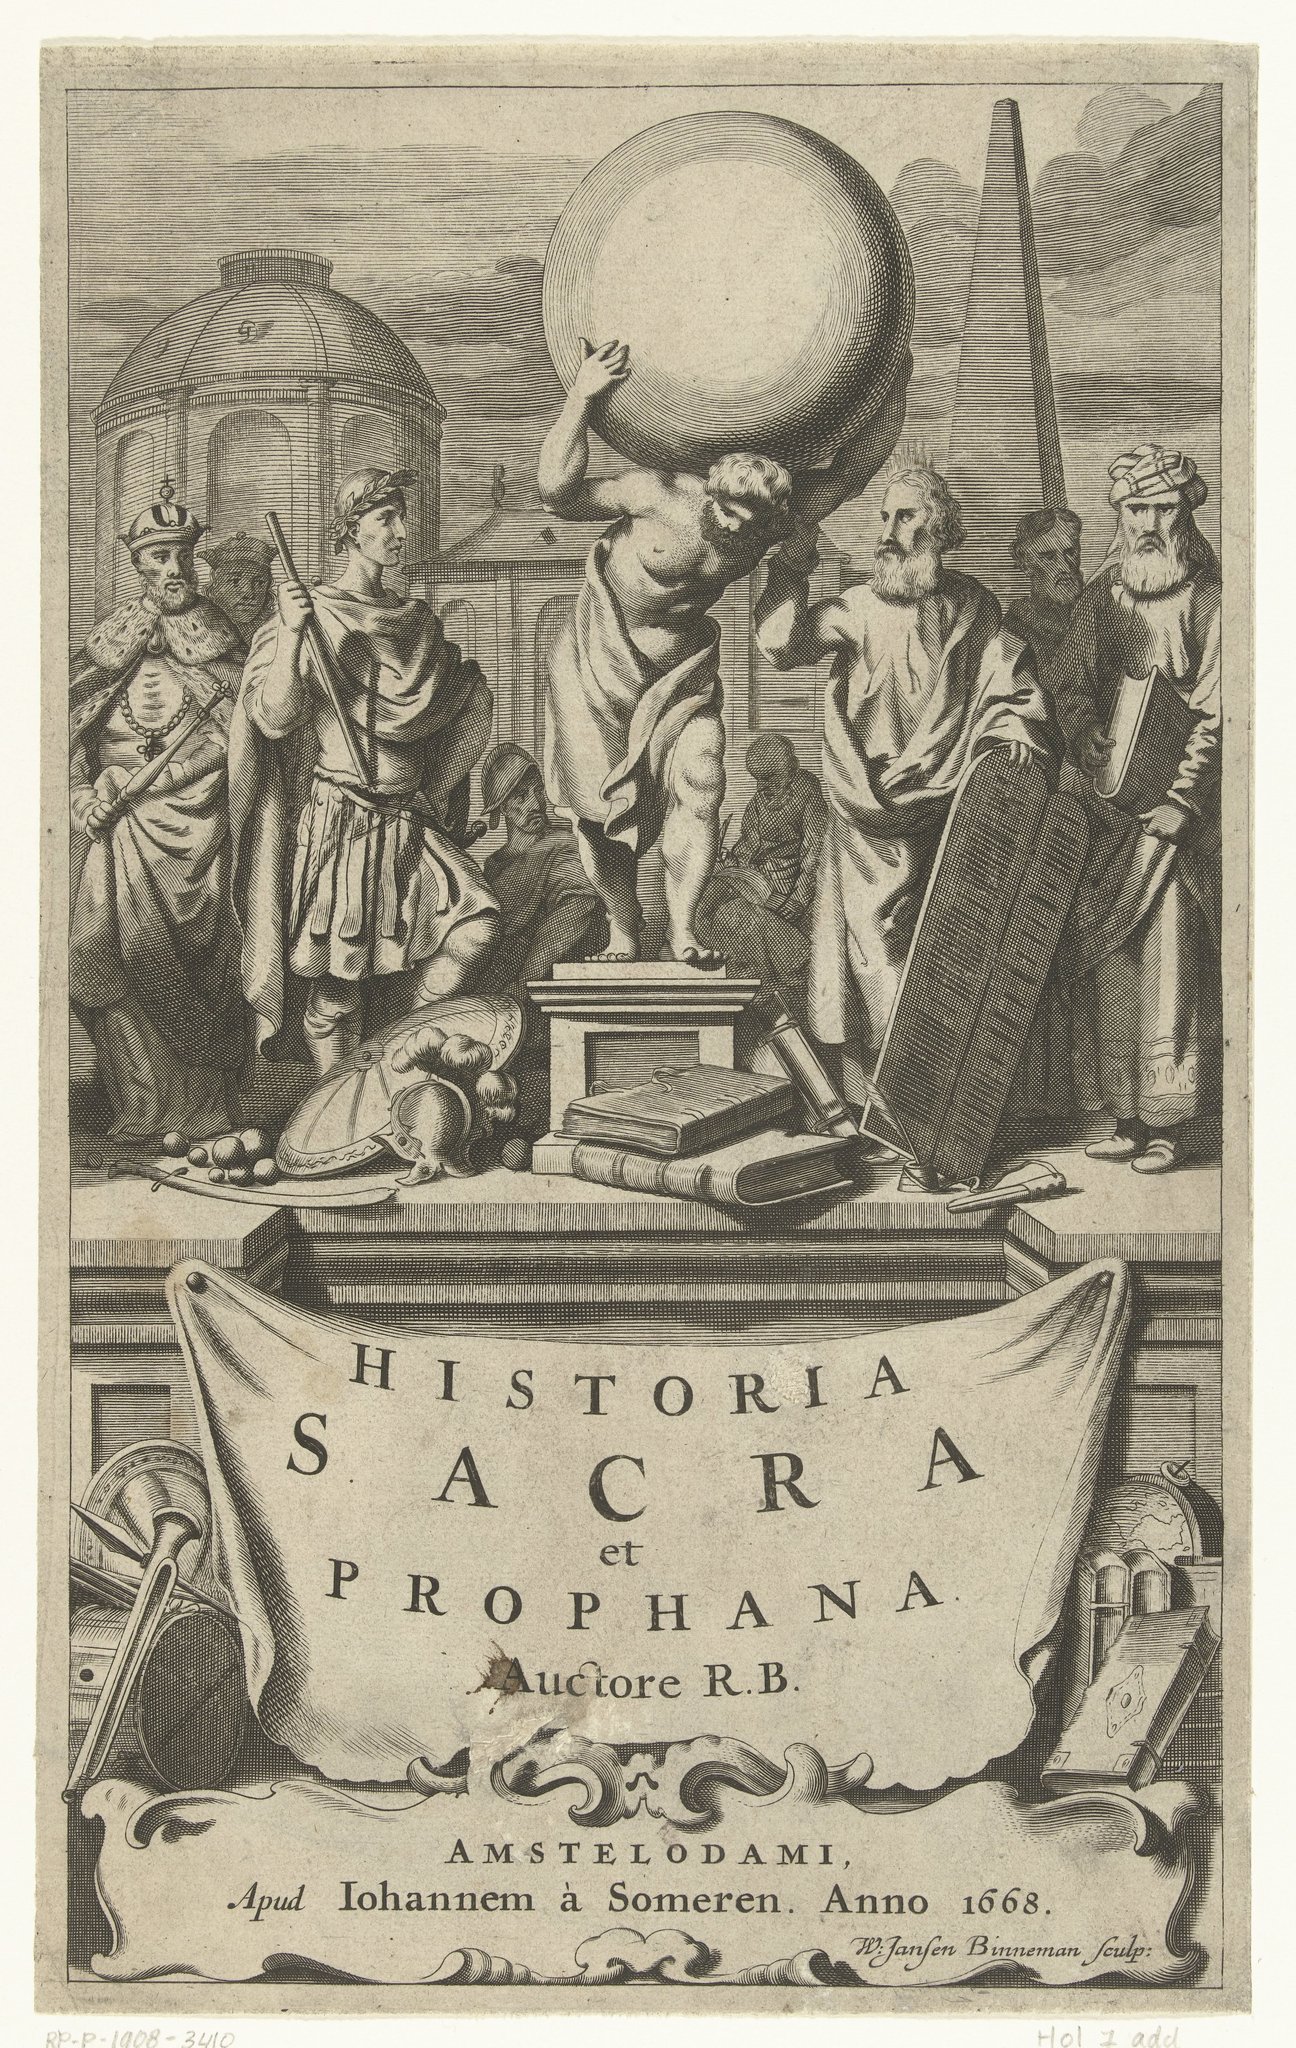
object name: print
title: Bijbelse, mythologische en historische figuren met hun attributen staan op voetstuk met titel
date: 1668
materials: paper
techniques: engraving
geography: netherlands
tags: atlas supporting the heavens on his shoulders, title-page, (story of) alexander the great, moses (not in biblical context); possible attributes: rays of light or horns on his head, rod, tables of the law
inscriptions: date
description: Enkele hoofdpersonen uit het boek zijn in een groep op een voetstuk geplaatst. Herkenbaar zijn Alexander de Grote, Atlas met de wereldbol op zijn schouders en Mozes met de tafelen der wet. Verder zijn koningen en profeten weergegeven. Op een doek dat op het voetstuk gespannen is staat de titel van de uitgave.